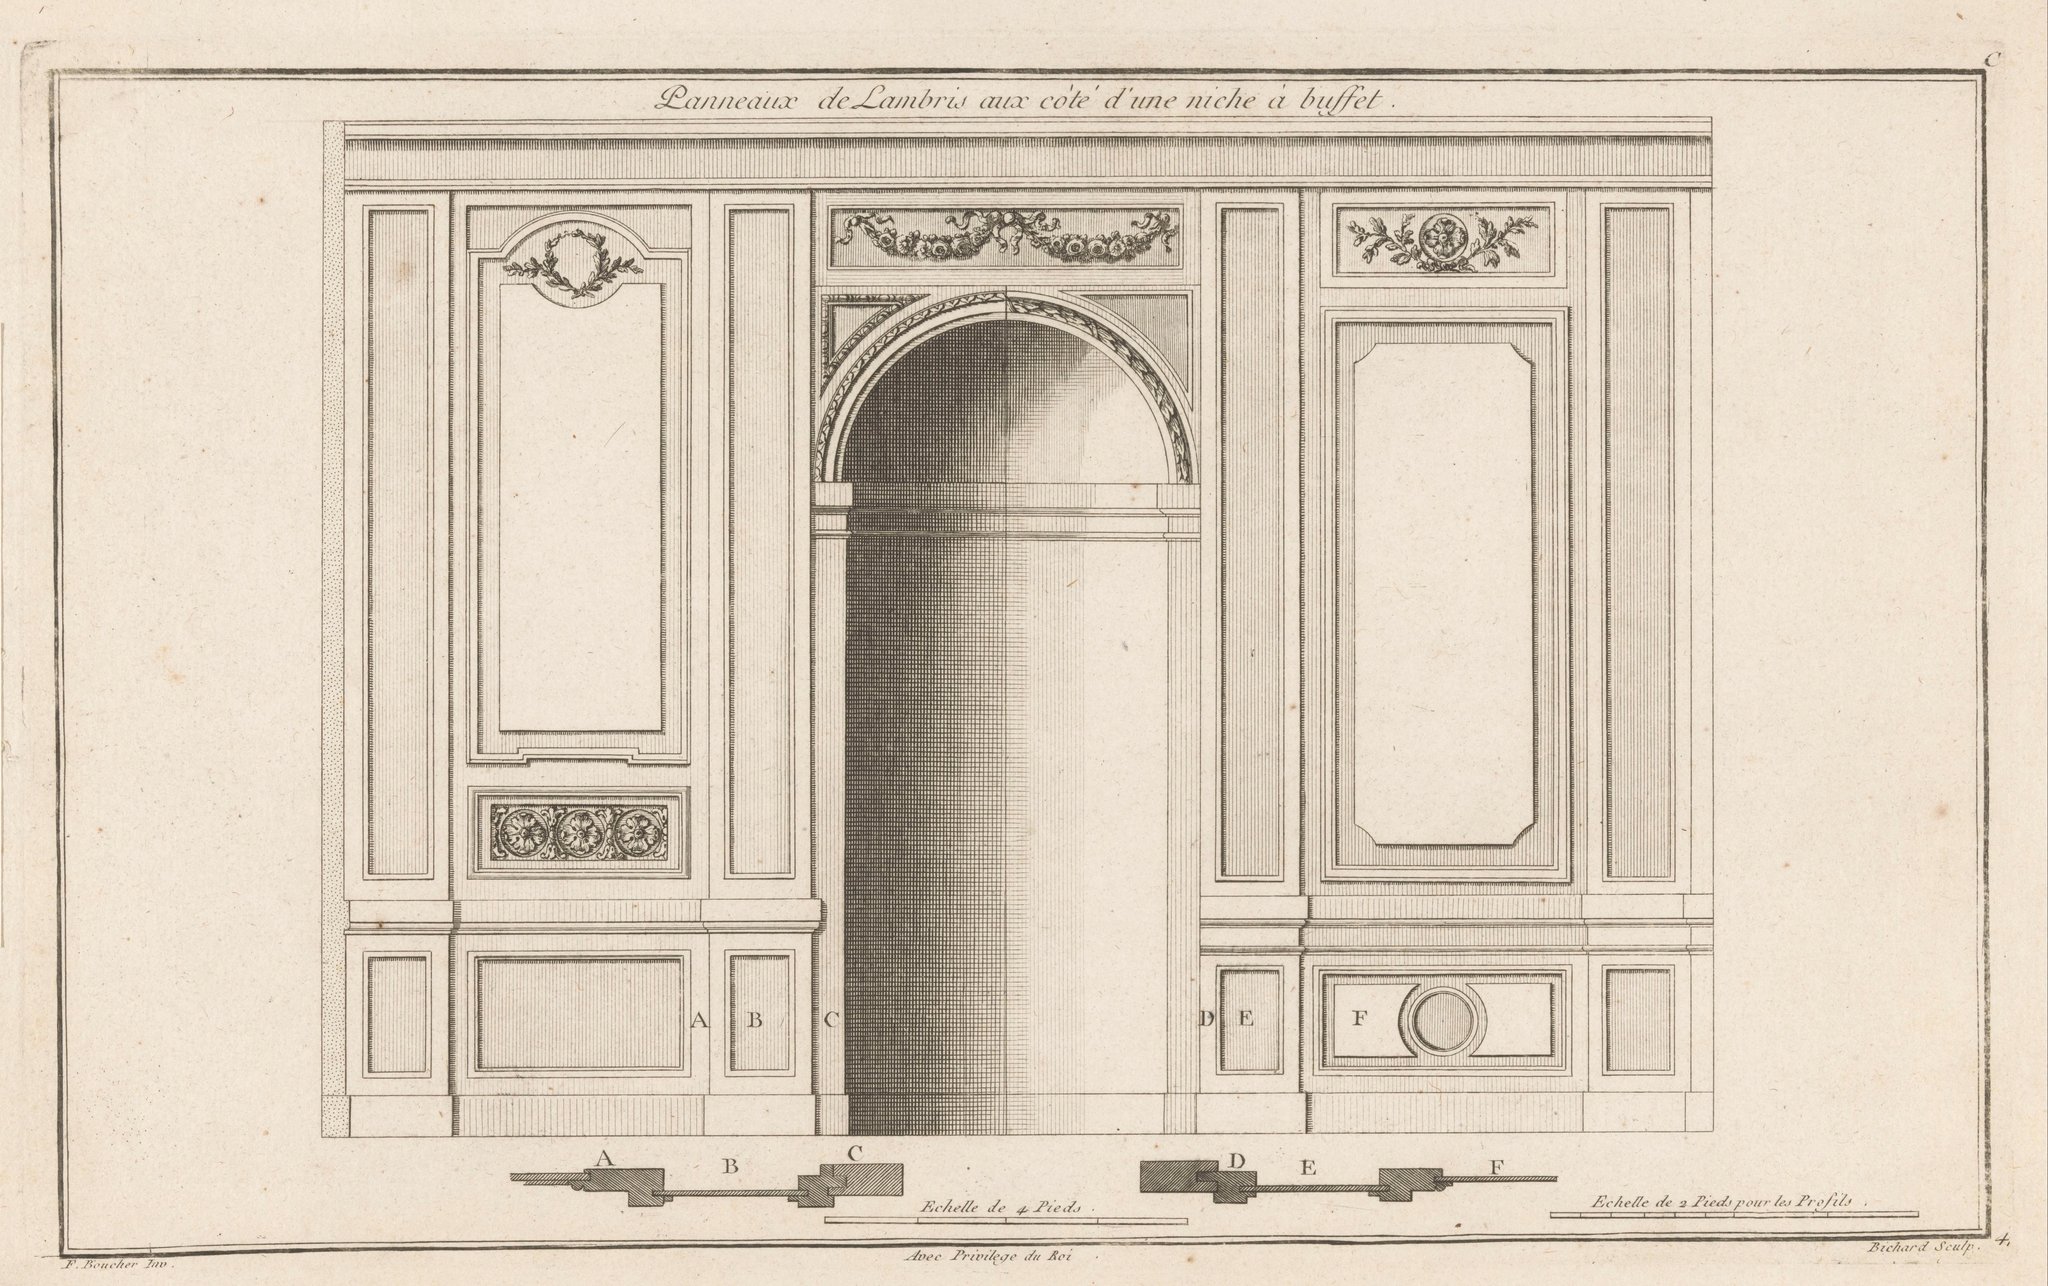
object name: print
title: Panelen en nis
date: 1752-1769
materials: paper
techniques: engraving, etching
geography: paris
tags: panelling, 'concha' ~ architecture, ornament ~ festoon, garland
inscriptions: collector's mark: Lugt 2760, collector's mark: Lugt 2228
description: Ontwerp en profiel van panelen aan weerszijden van een halfronde nis, daarboven guirlandes.